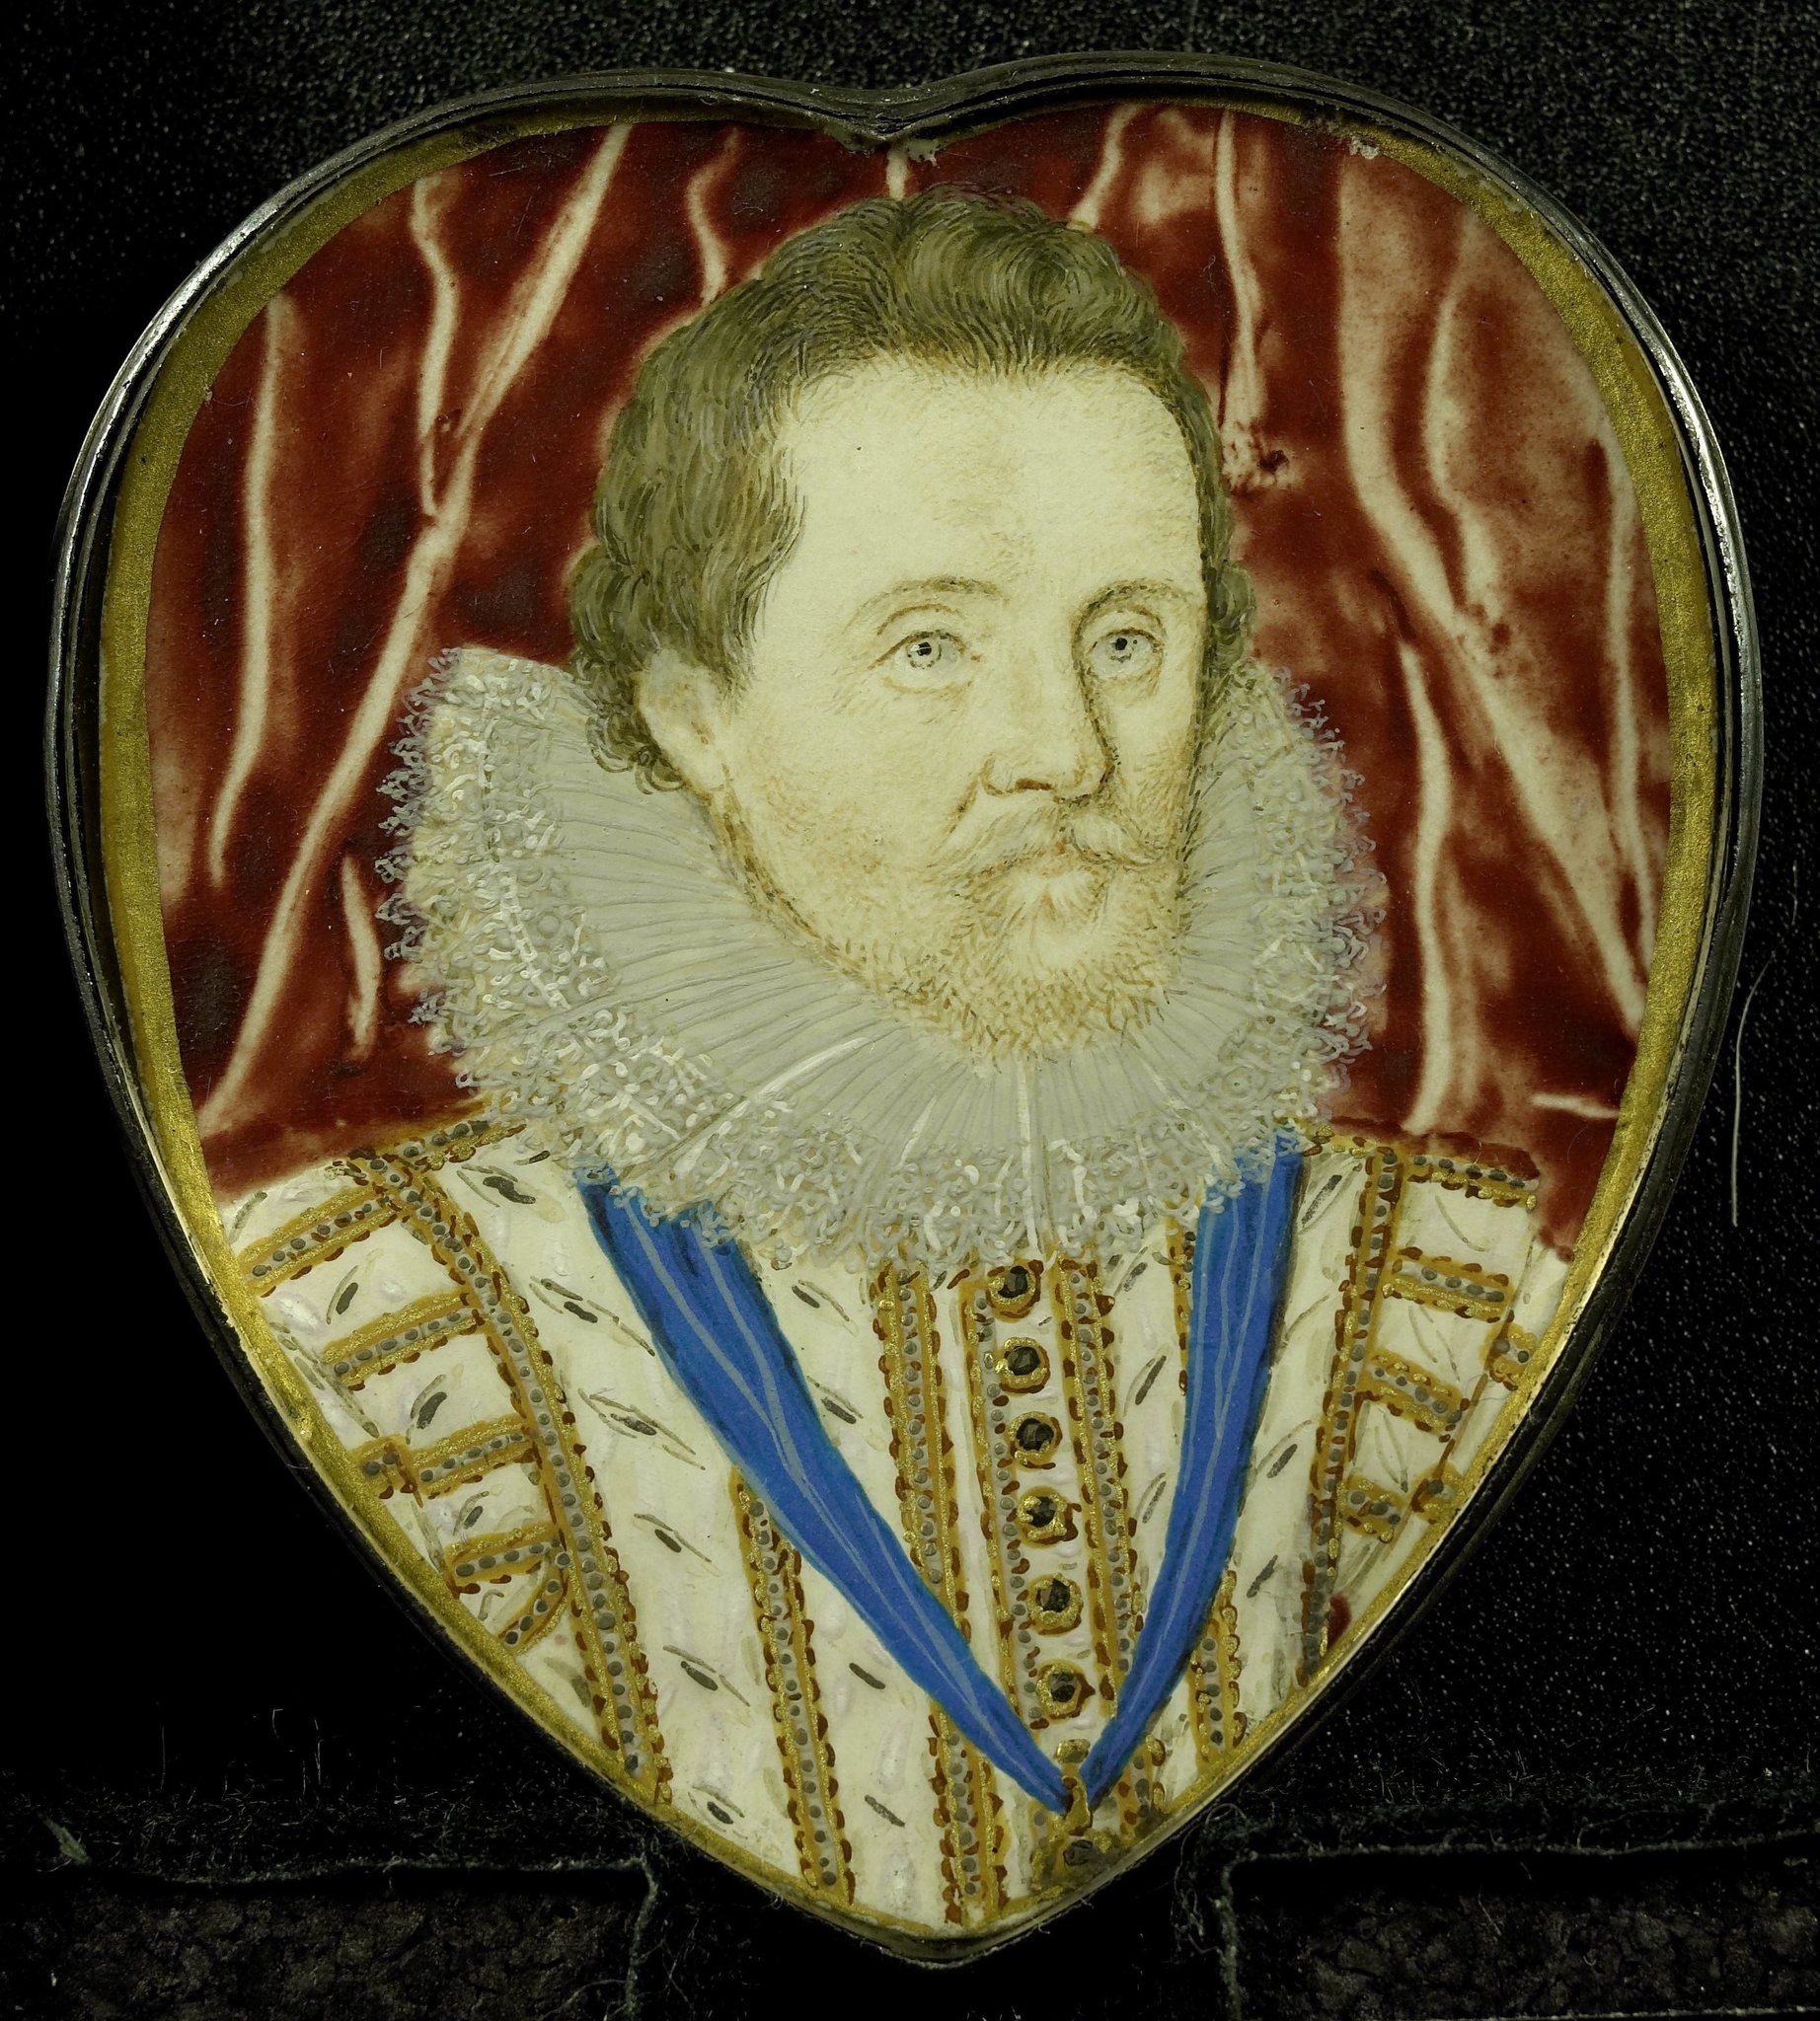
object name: painting, miniature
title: Portrait of James I (1566-1625), King of Engeland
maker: lawrence hilliard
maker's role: miniatuurschilder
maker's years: 1581-1640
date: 1600-1625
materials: cardboard, glass, silver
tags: jacobus i (koning van engeland)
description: Portret van Jacobus I (1566-1625), koning van Engeland. Buste, iets naar rechts. Onderdeel van de collectie portretminiaturen.